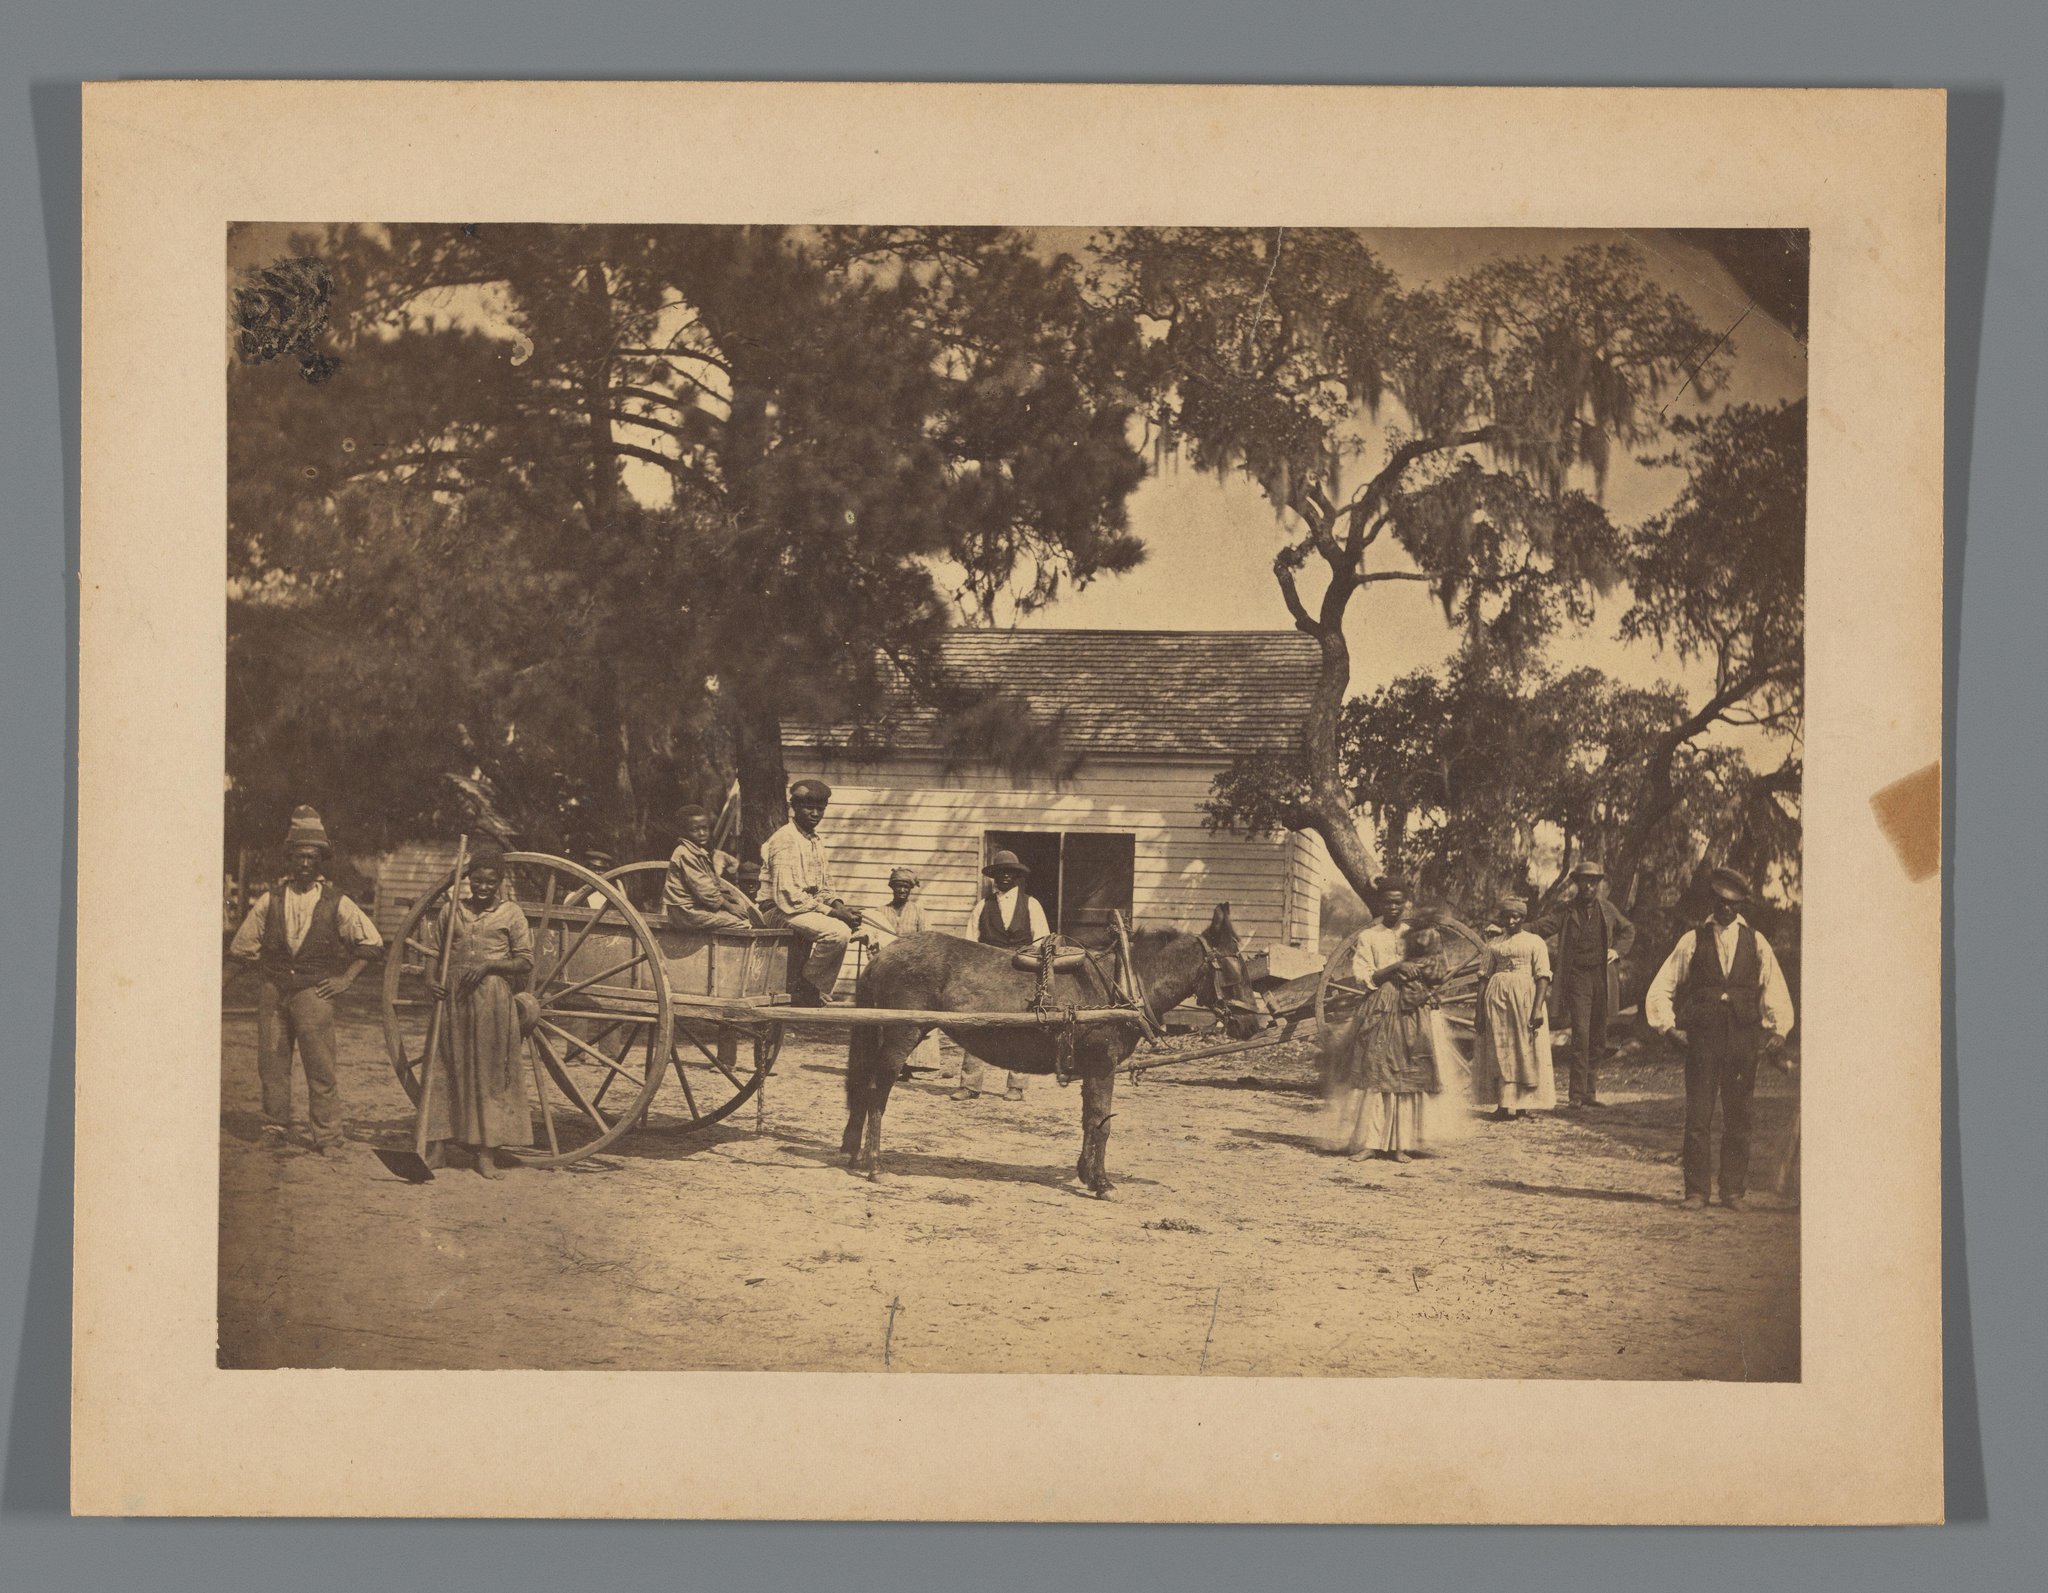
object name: photograph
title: Enslaved Workers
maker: henry p. moore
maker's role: fotograaf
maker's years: 1835-1911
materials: cardboard, paper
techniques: albumen print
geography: south carolina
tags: south carolina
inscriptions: inscription: ‘Edisto Island, SC, April or May 1862’